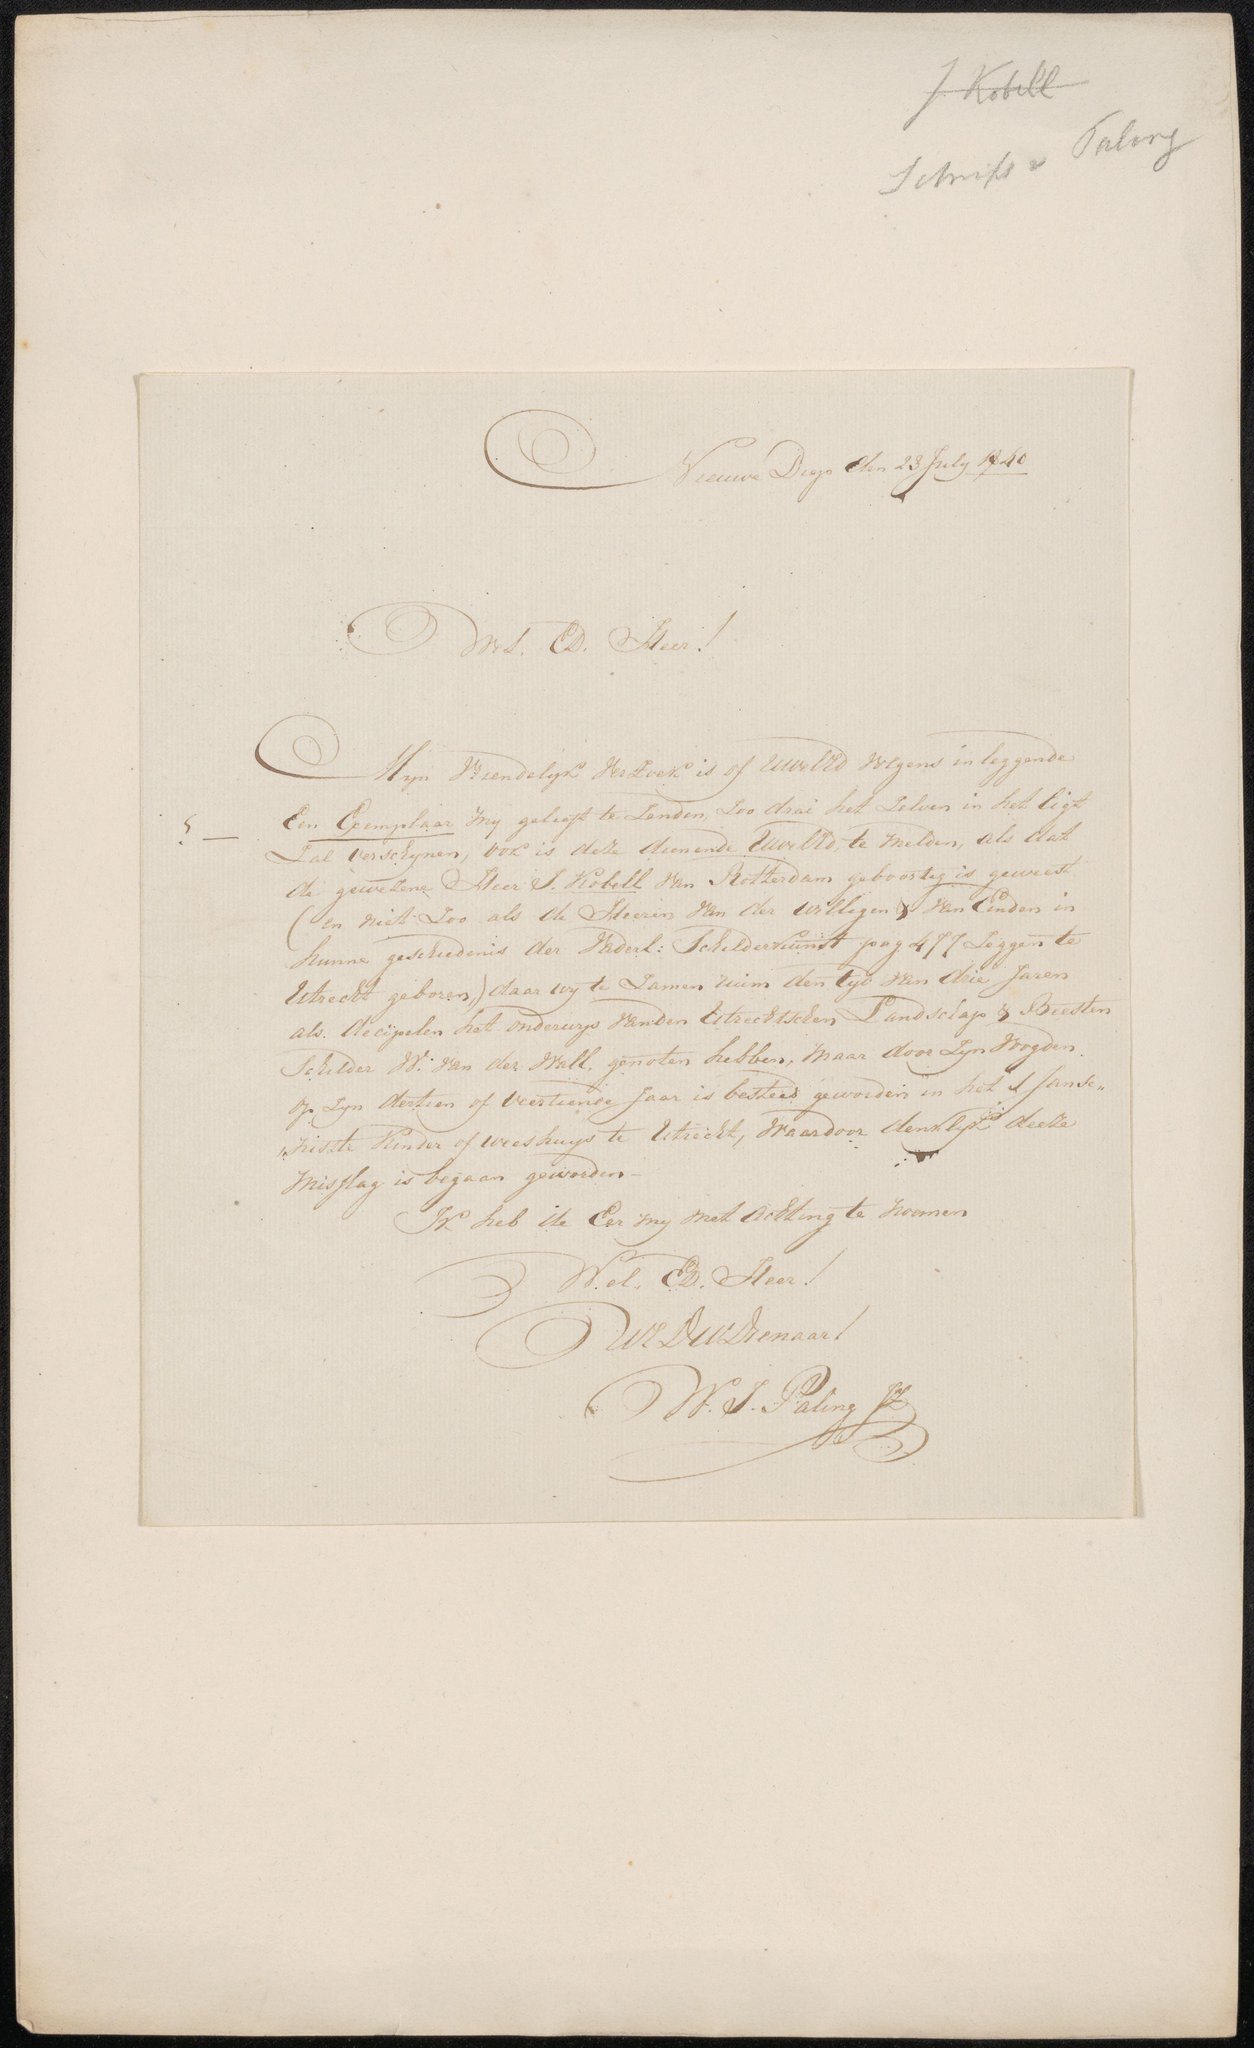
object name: letter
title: Brief aan Johannes Immerzeel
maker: willem jan paling jz.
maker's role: print maker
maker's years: 1776-1848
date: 1840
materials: ink, paper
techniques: pen, writing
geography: nieuwediep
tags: publisher, johannes immerzeel, utrecht, willem rutgaert van der wall, rotterdam, draughtsman, jan kobell (i), haarlem, adriaan van der willigen, painting (including book-illumination, miniature-painting)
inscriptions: watermark